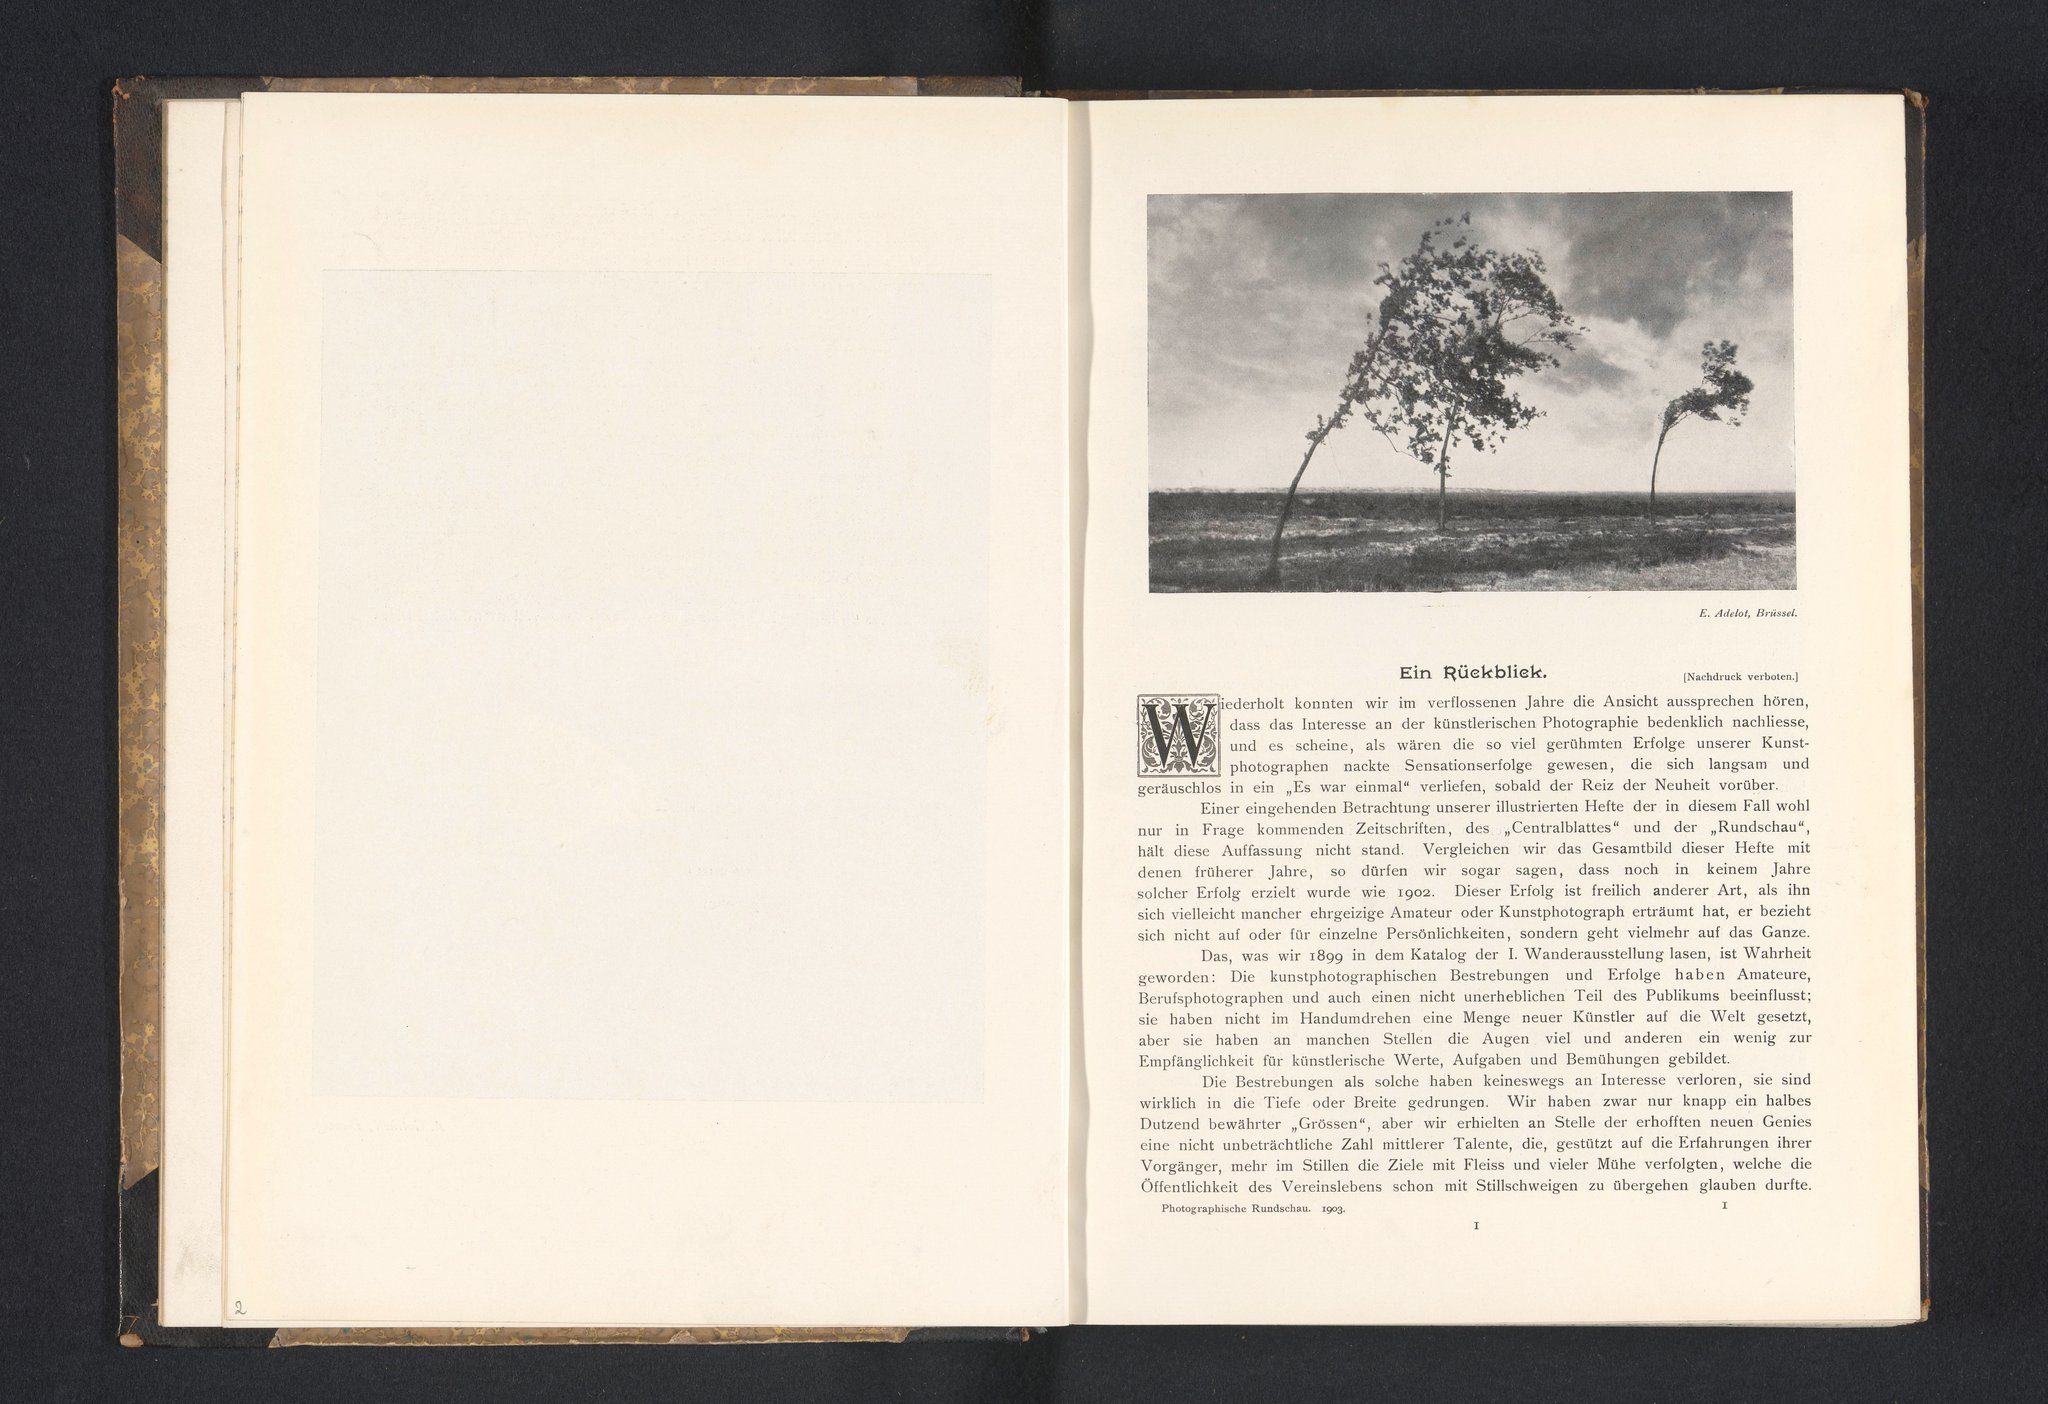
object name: photomechanical print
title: Landschap met drie bomen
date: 1898-1903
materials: paper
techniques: autotype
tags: trees, landscapes